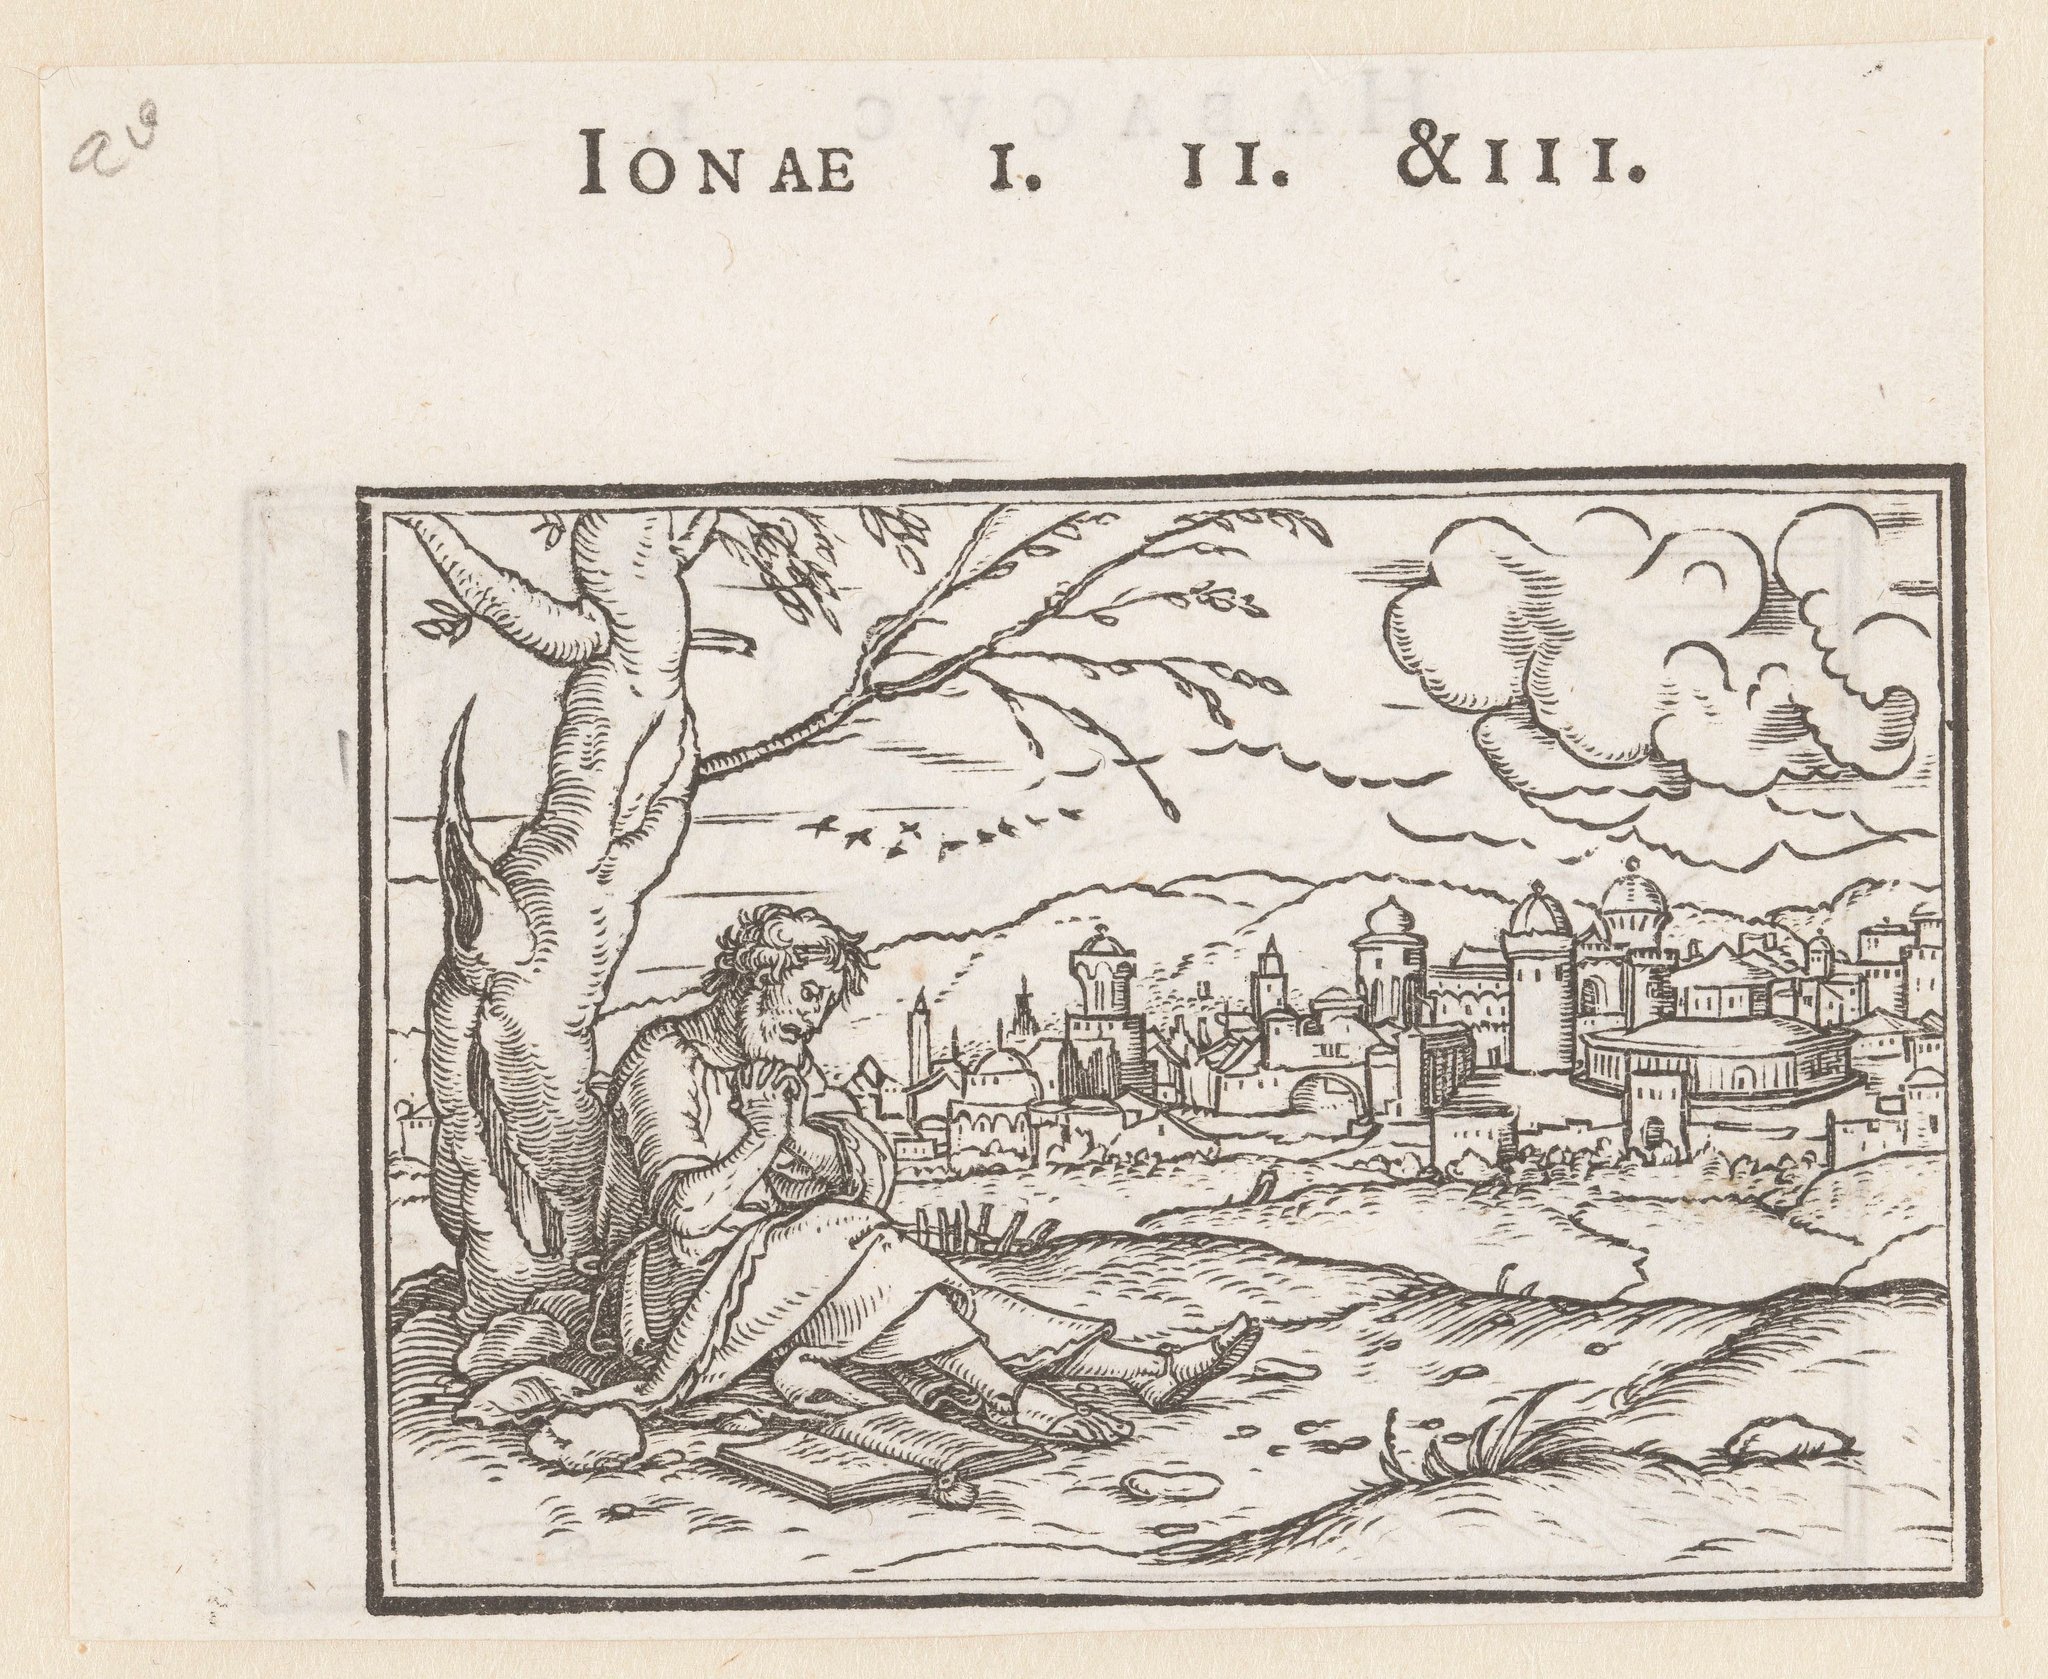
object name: print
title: Jona zit onder de wonderboom in de buurt van Nineve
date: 1538-1543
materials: paper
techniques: woodcut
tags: the prophet jonah withdraws from nineveh; he builds a booth and while enjoying the shade of a plant (gourd or vine) which god made grow for him, he awaits the destiny of the city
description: Dit houtblok werd niet gebruikt in de eerste uitgave van Biblia Utriusque Testamenti iuxta Vulgatam Translationem, Lyon, M. en G. Trechsel (voor Hugo à Porta) 1538 maar in een latere druk. Zie Hollstein German 100, nr. 88.